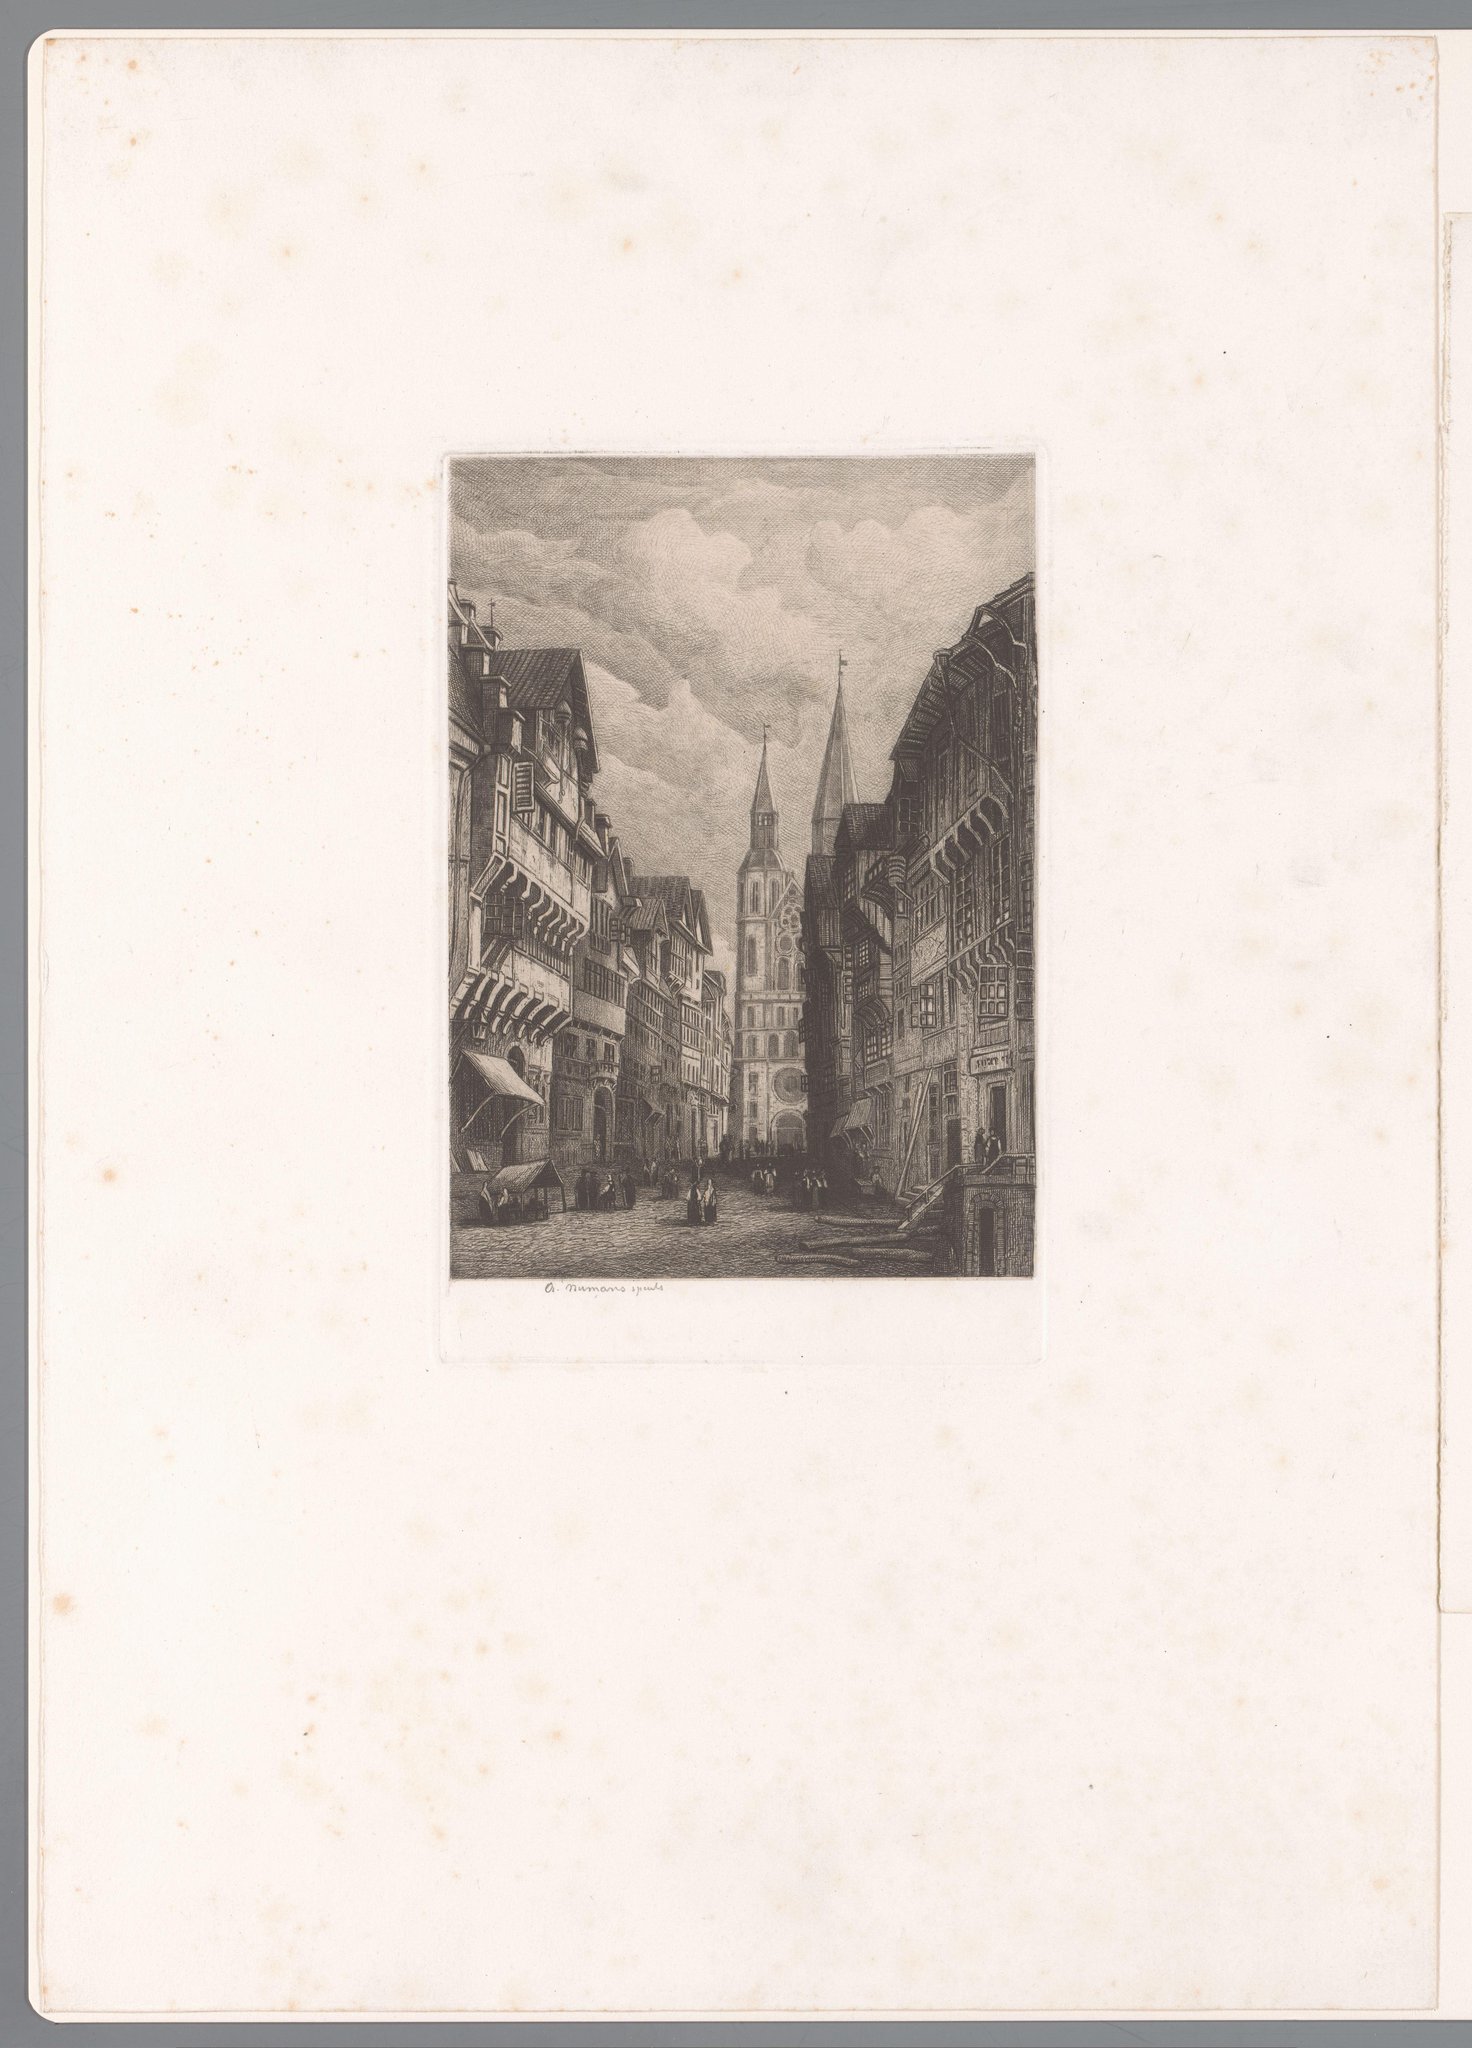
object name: print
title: Gezicht op een straat in Braunschweig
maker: auguste numans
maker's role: print maker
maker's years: 1823-1883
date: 1833-1879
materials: paper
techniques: etching, intaglio, roulette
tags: church (exterior), street (+ city(-scape) with figures, staffage)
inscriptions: collector's mark: Lugt 2228